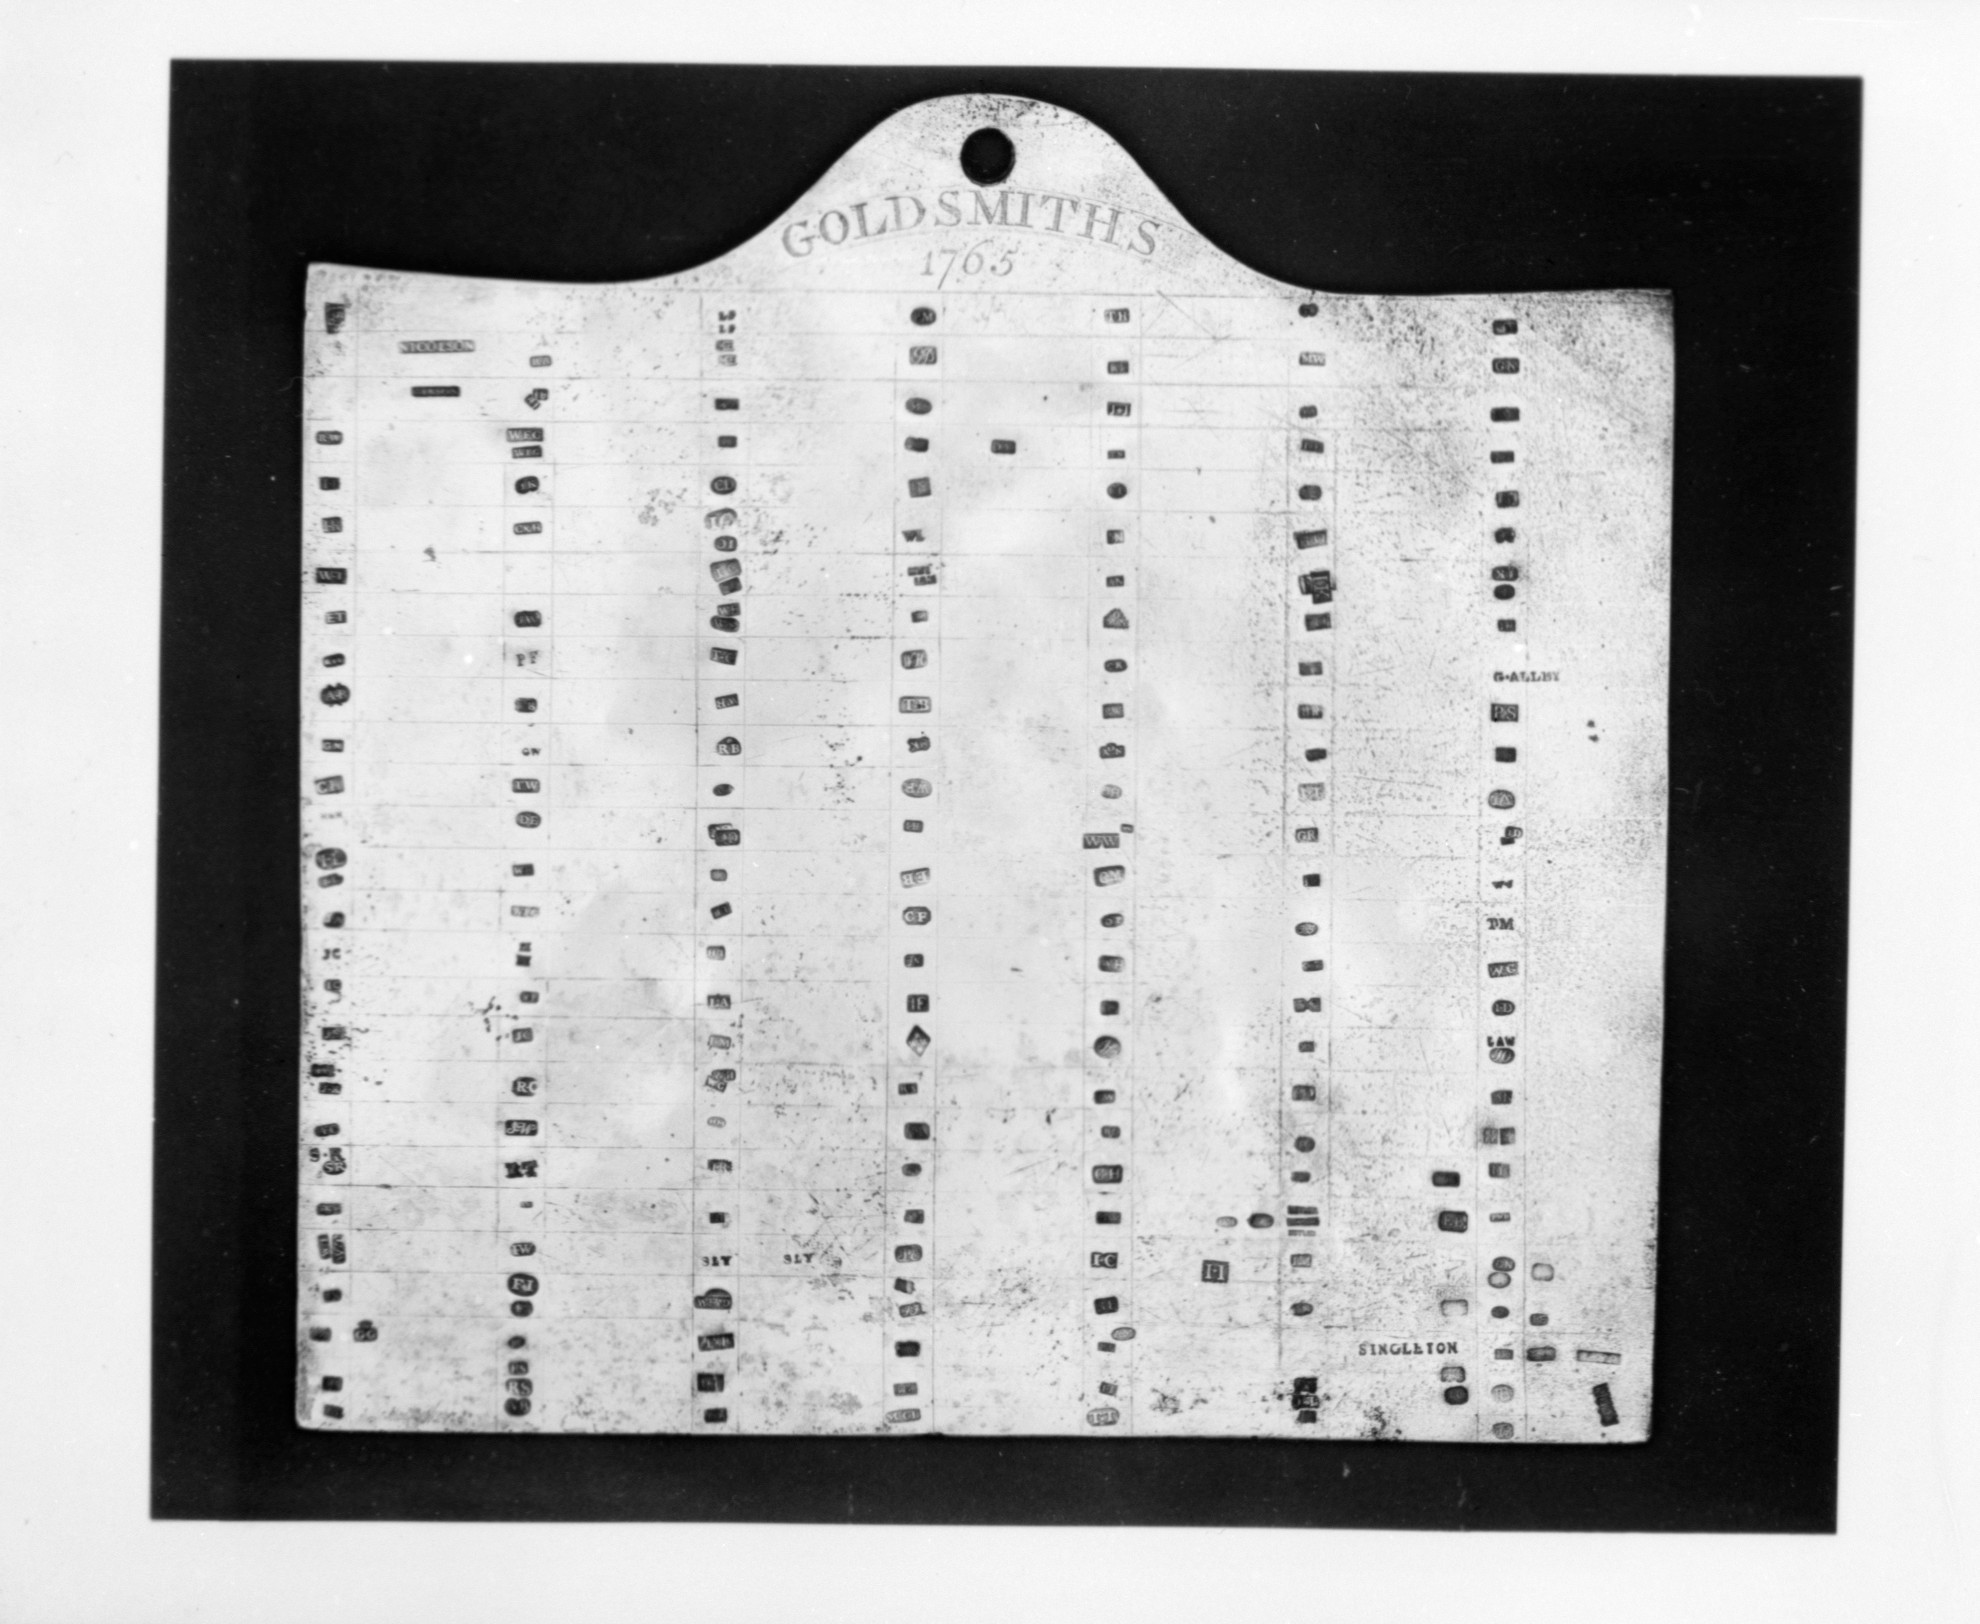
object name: touch plate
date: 1801-1900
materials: copper, silver